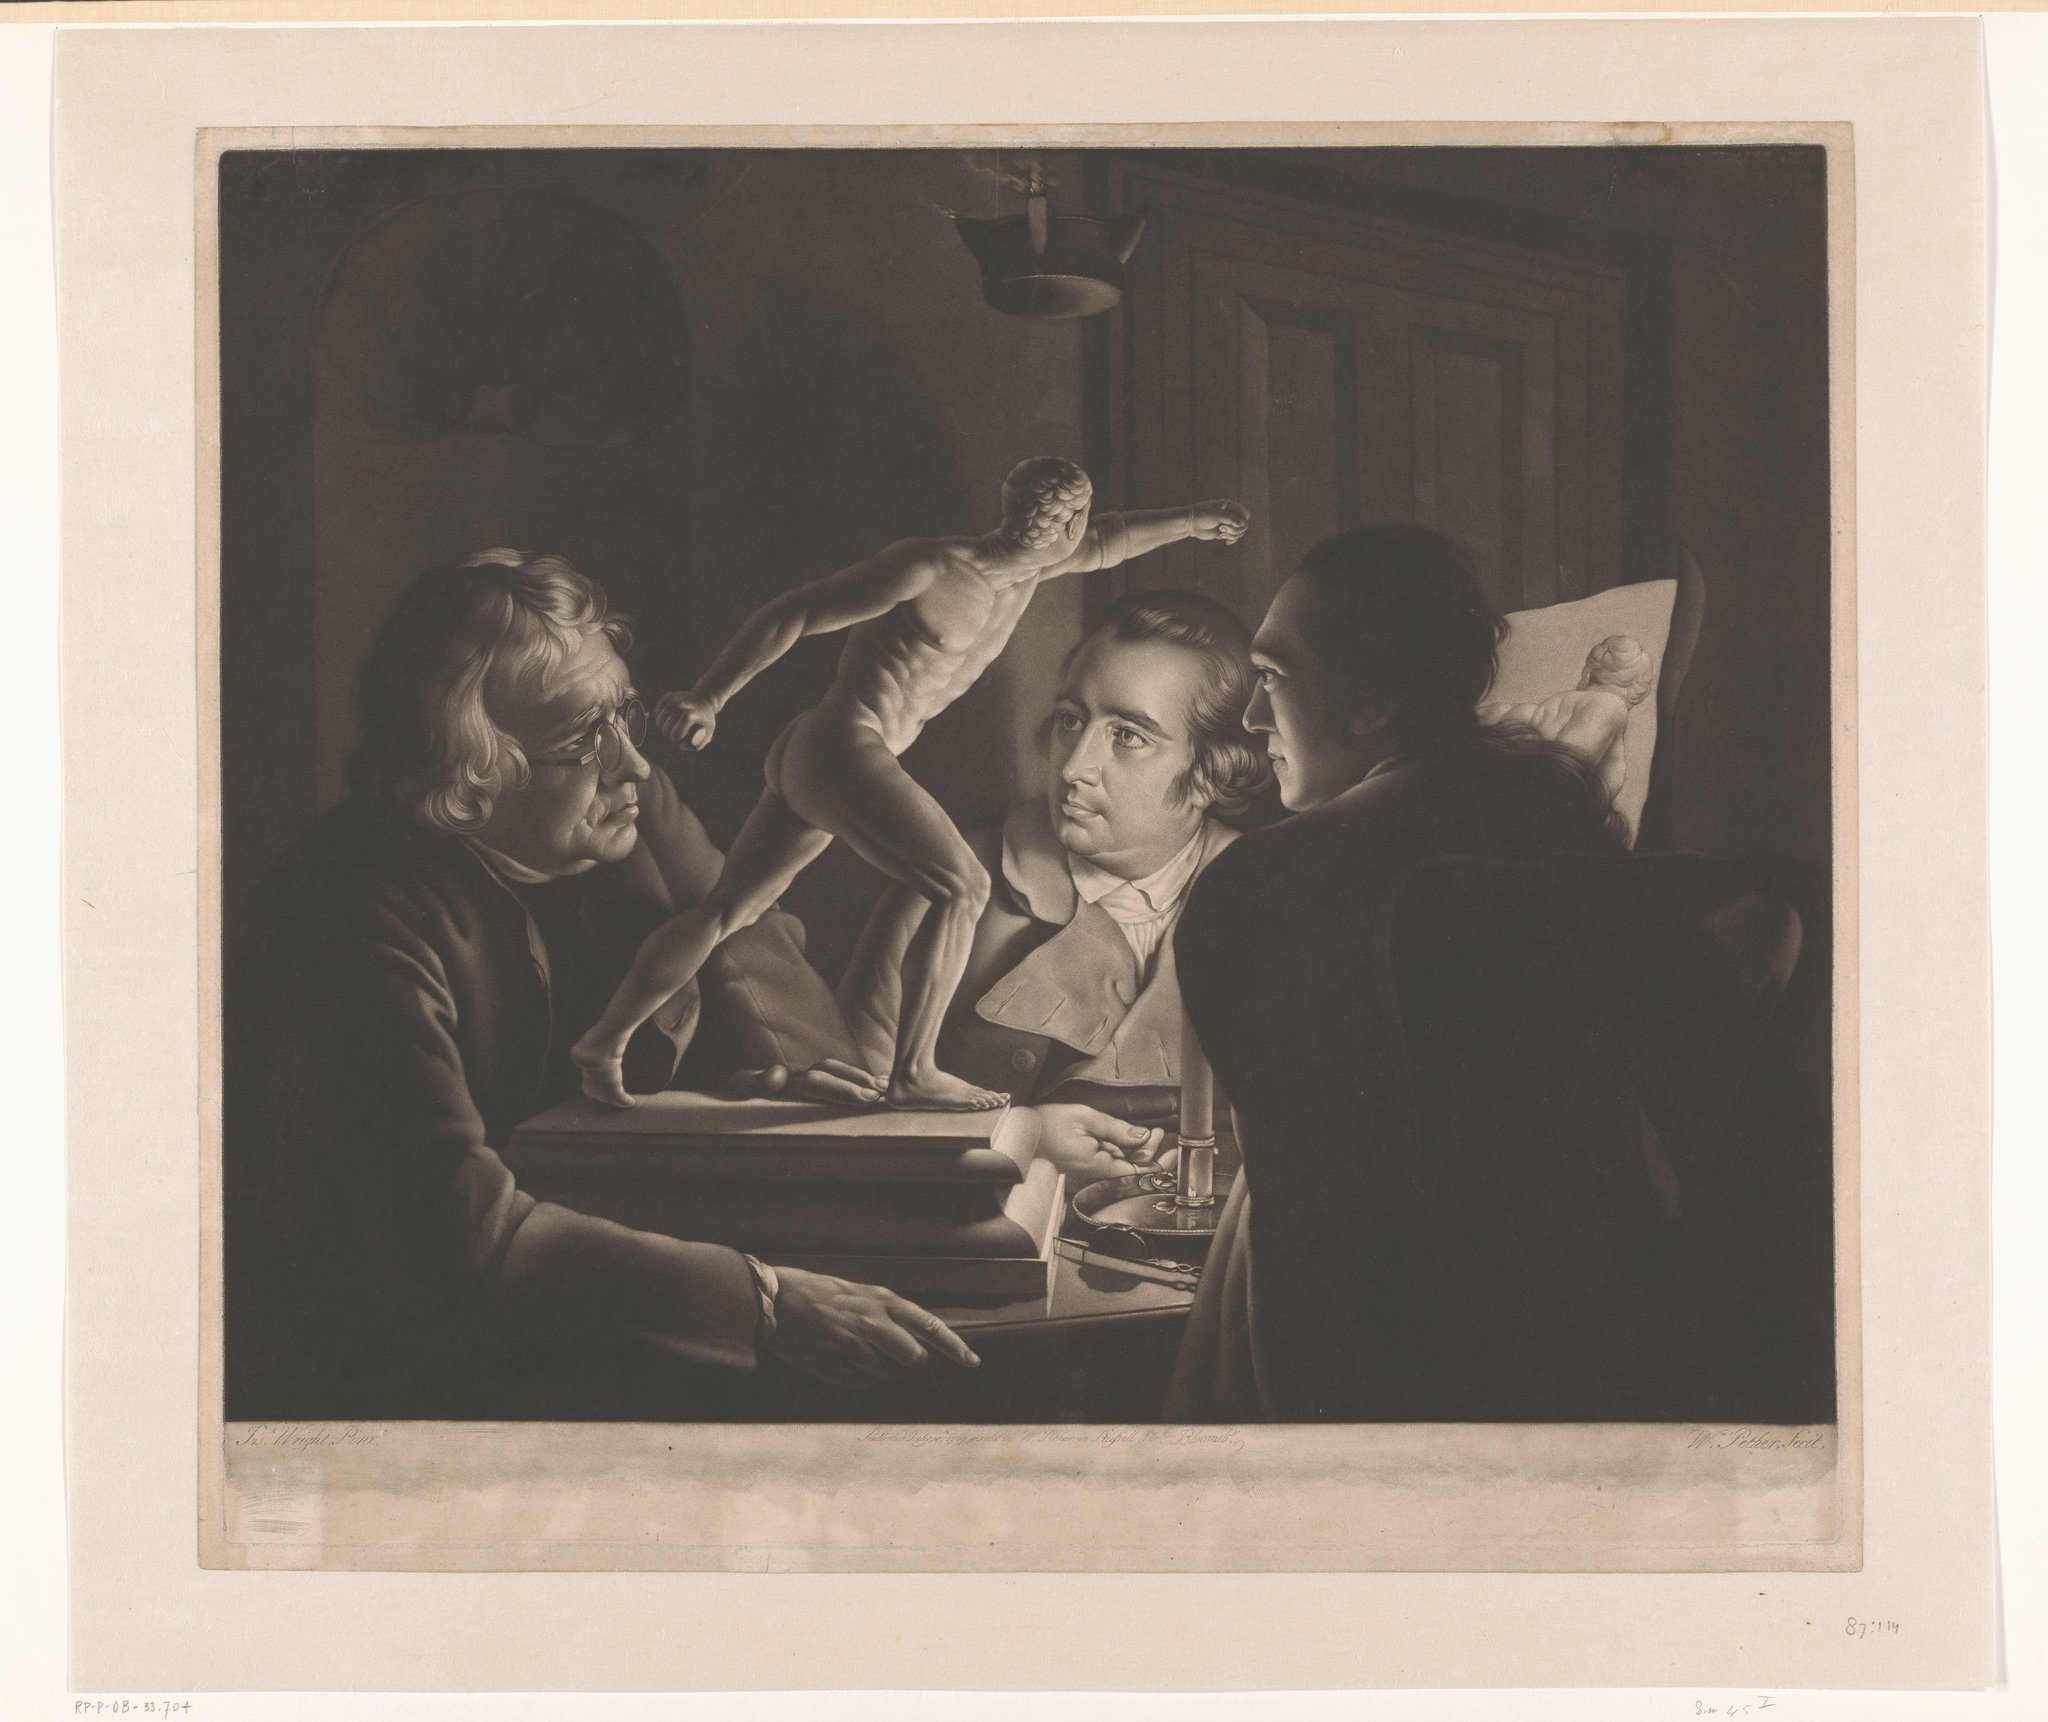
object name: print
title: Drie mannen bekijken een model van de Borghese Gladiator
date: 1769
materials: paper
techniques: mezzotint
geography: london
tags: painter, joseph wright of derby, piece of sculpture, reproduction of a piece of sculpture, draughtsman studying classical remains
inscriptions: collector's mark: Lugt 2228, collector's mark: Lugt 2178, collector's mark: Lugt 2760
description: De drie heren, van wie de jongeman die de tekening ophoudt misschien Joseph Wright of Derby zelf voorstelt, vergelijken bij kaarslicht een sterk verkleinde copie van de zogenaamde gladiator Borghese met een tekening van het beeld. Het origineel was in 1611 in Rome opgegraven en verworven door kardinaal Scipione Borghese. Het behoorde tot de beroemdste antieke beelden van Rome en er zijn talloze copieën naar gemaakt. Wright of Derby, die het schilderij rond 1764 maakte, moet in zijn omgeving een dergelijke copie hebben gekend. Hij ondernam zijn 'grand tour' in 1773 en kon het beeld toen pas in het echt bewonderen.